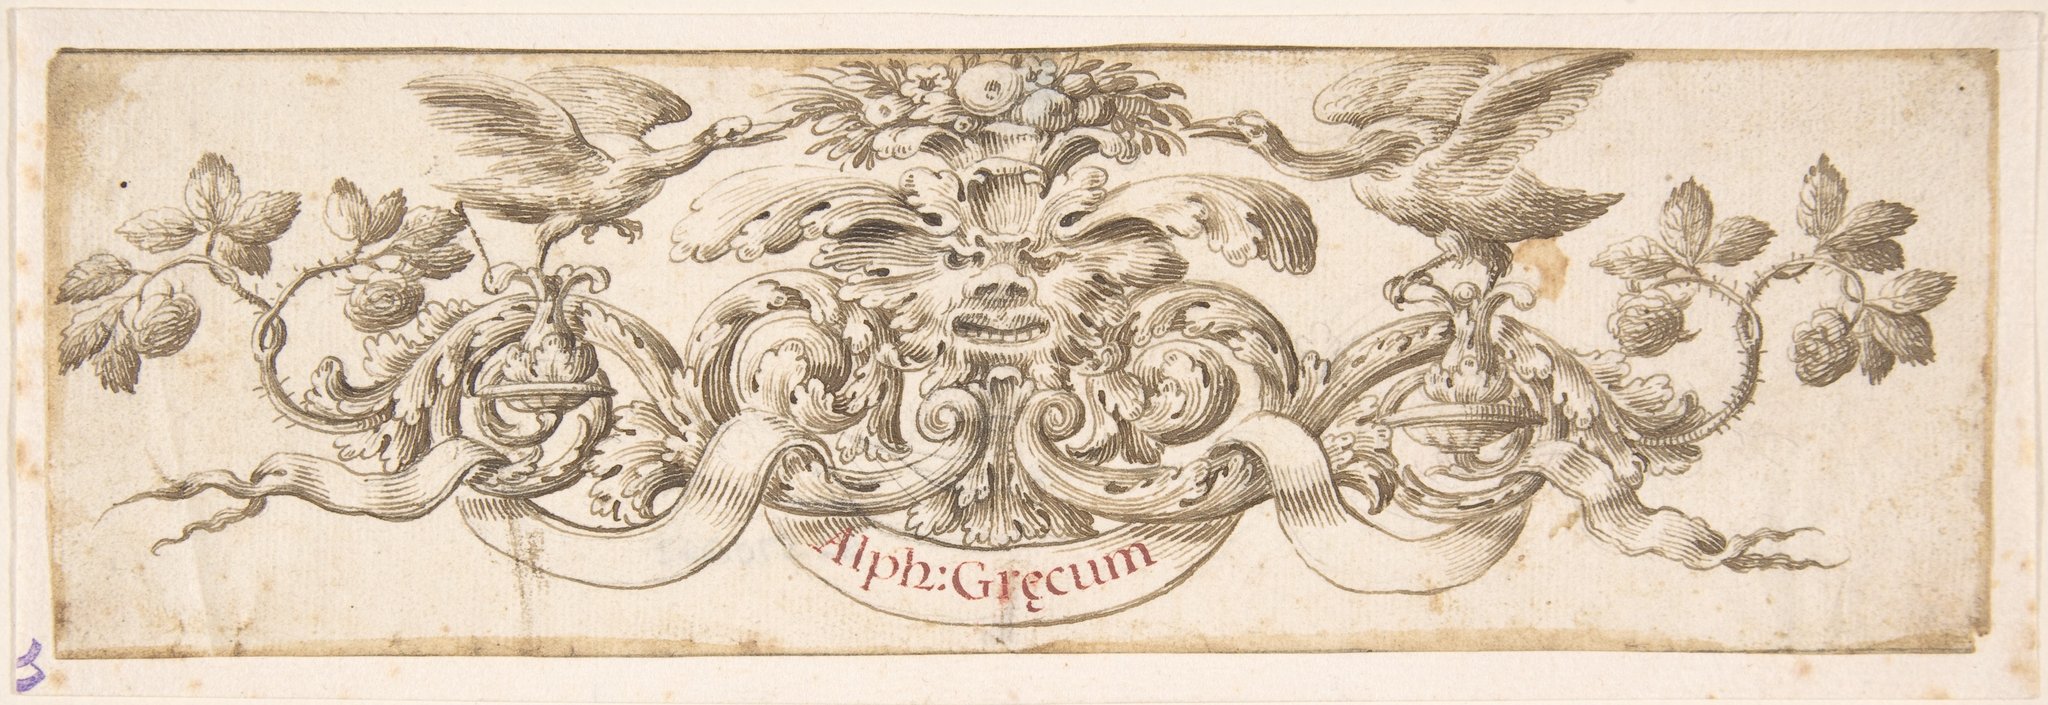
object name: drawing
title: Design for a Vignette Accompanying a Publication on the Greek Alphabet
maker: stefano della bella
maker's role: artist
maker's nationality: italian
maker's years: 1610-1664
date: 1630-1664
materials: ink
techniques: pen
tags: birds,ornament,flowers